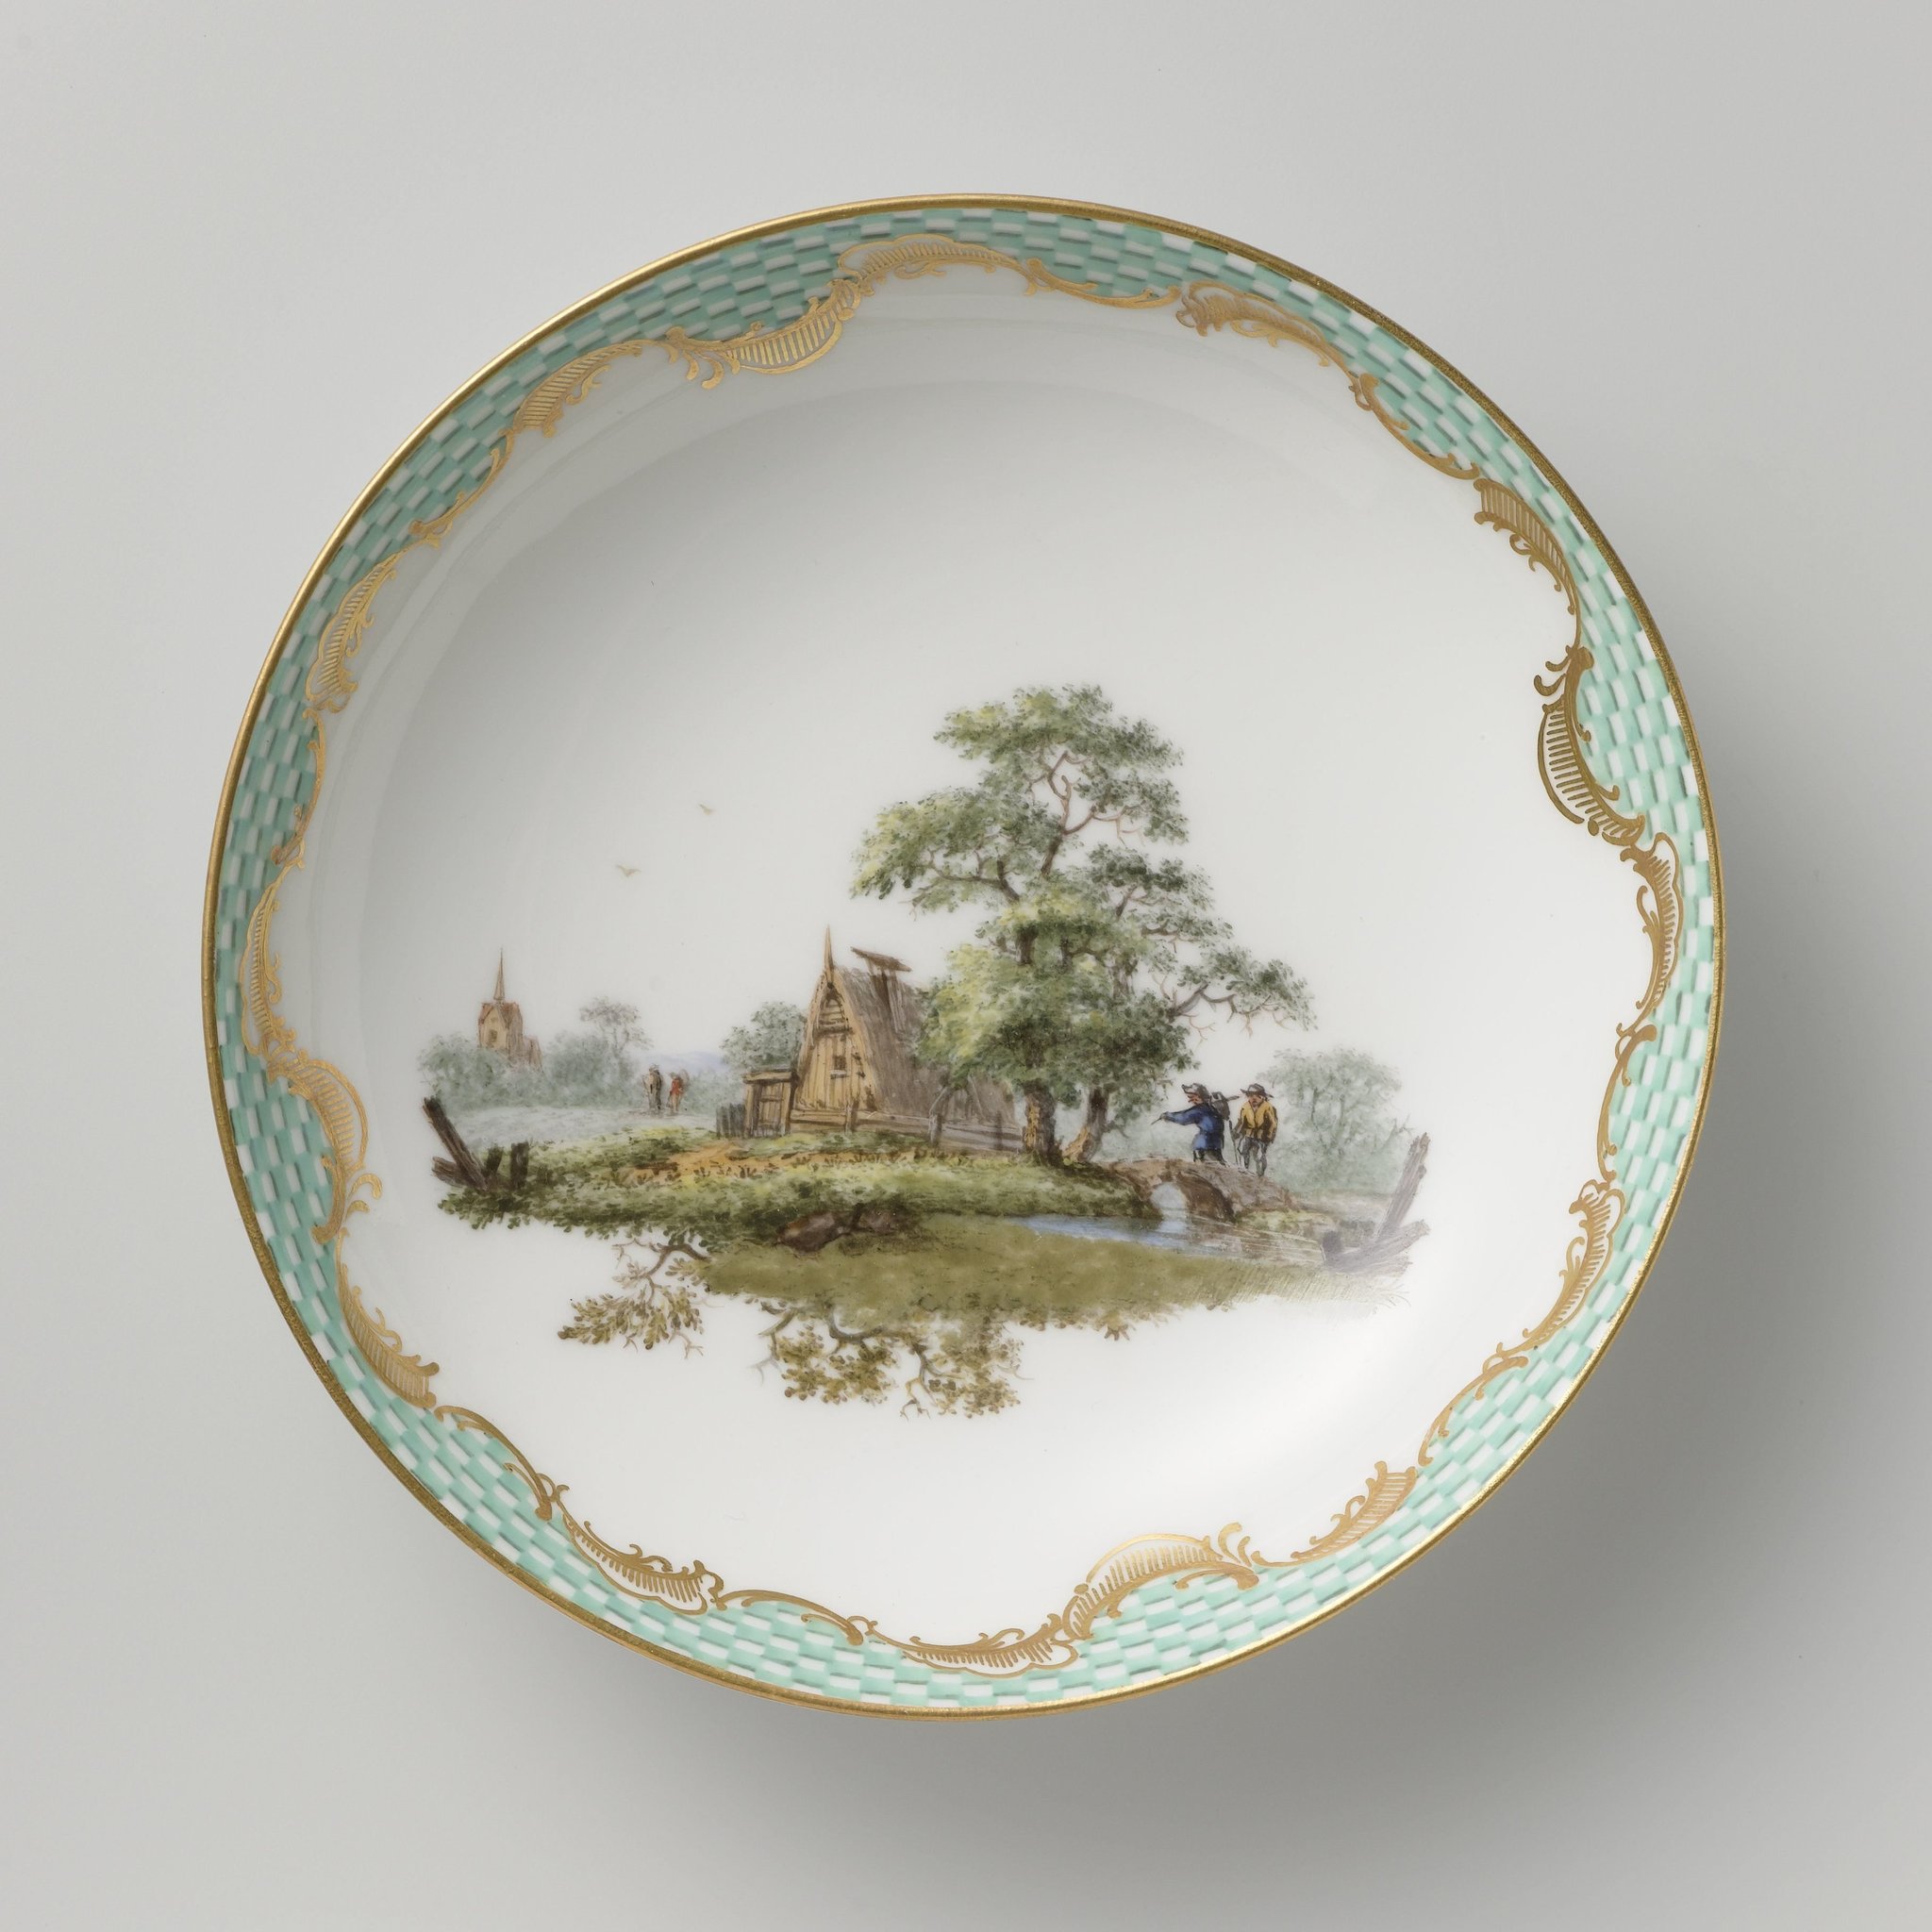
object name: platter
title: Schotel, veelkleurig beschilderd met een landschap met figuren.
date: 1777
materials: porcelain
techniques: painted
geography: meissen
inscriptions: mold mark, factory mark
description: Ronde schotel van beschilderd porselein. De schotel is beschilderd met landschappen waarin figuren en langs de rand een brede strook groen vlechtwerk. De schotel is gemerkt.